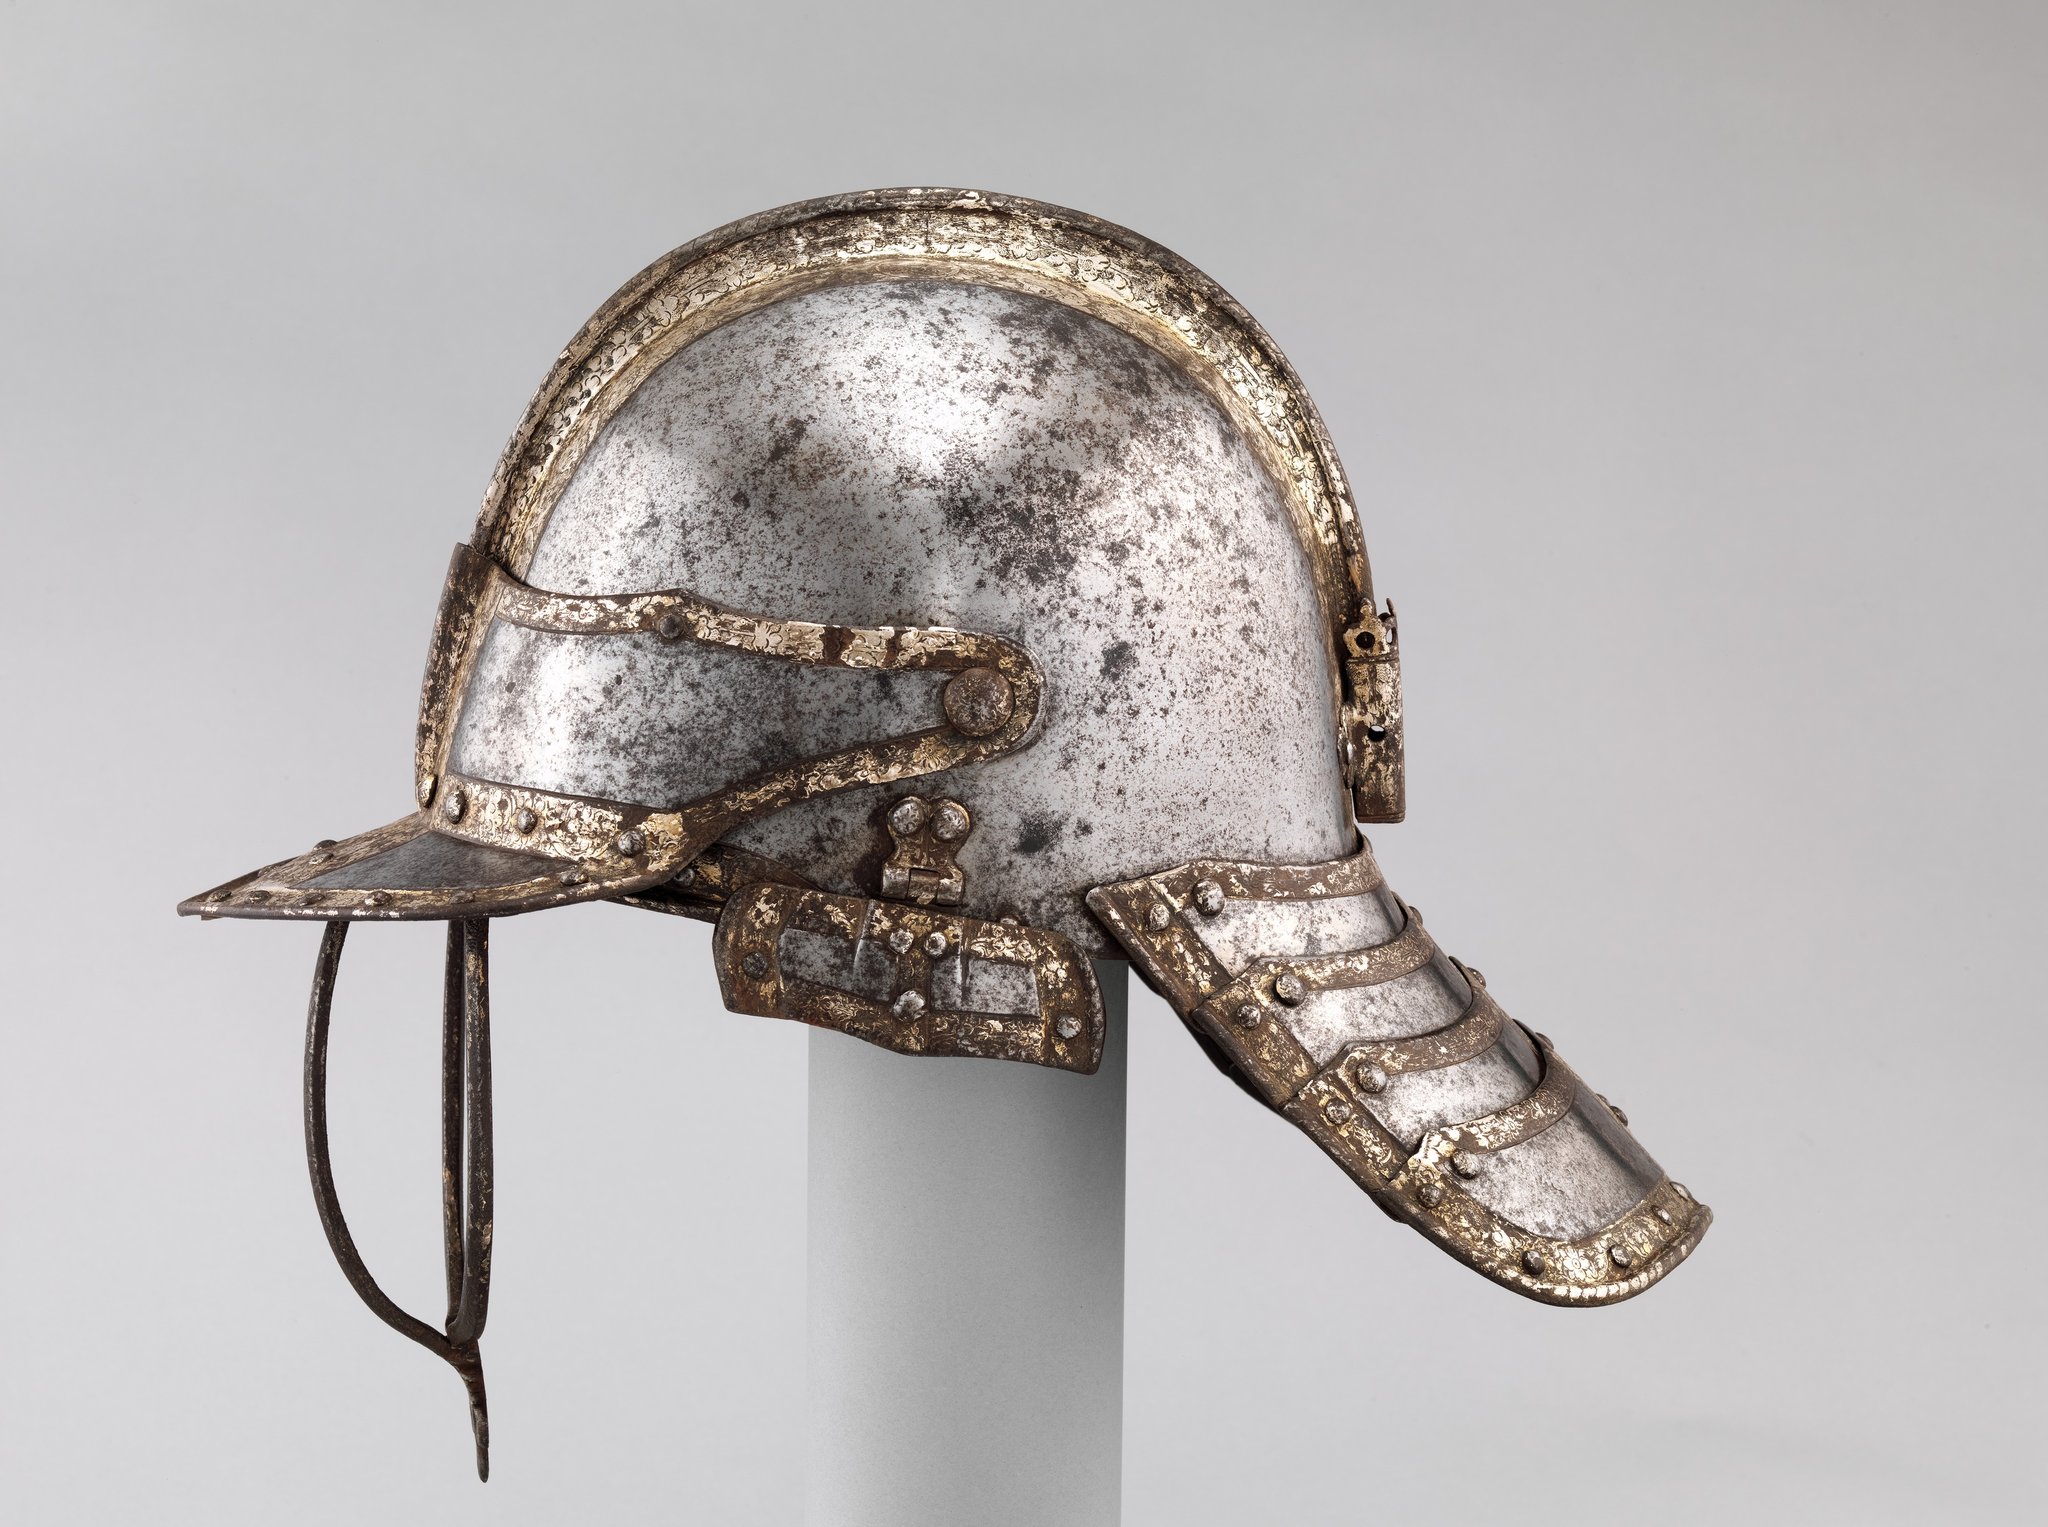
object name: helmet for a harquebusier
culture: british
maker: royal workshops at greenwich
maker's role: armorer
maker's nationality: british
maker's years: 1511-1650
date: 1630-1640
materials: copper alloy, gold, silver, steel, textile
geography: england